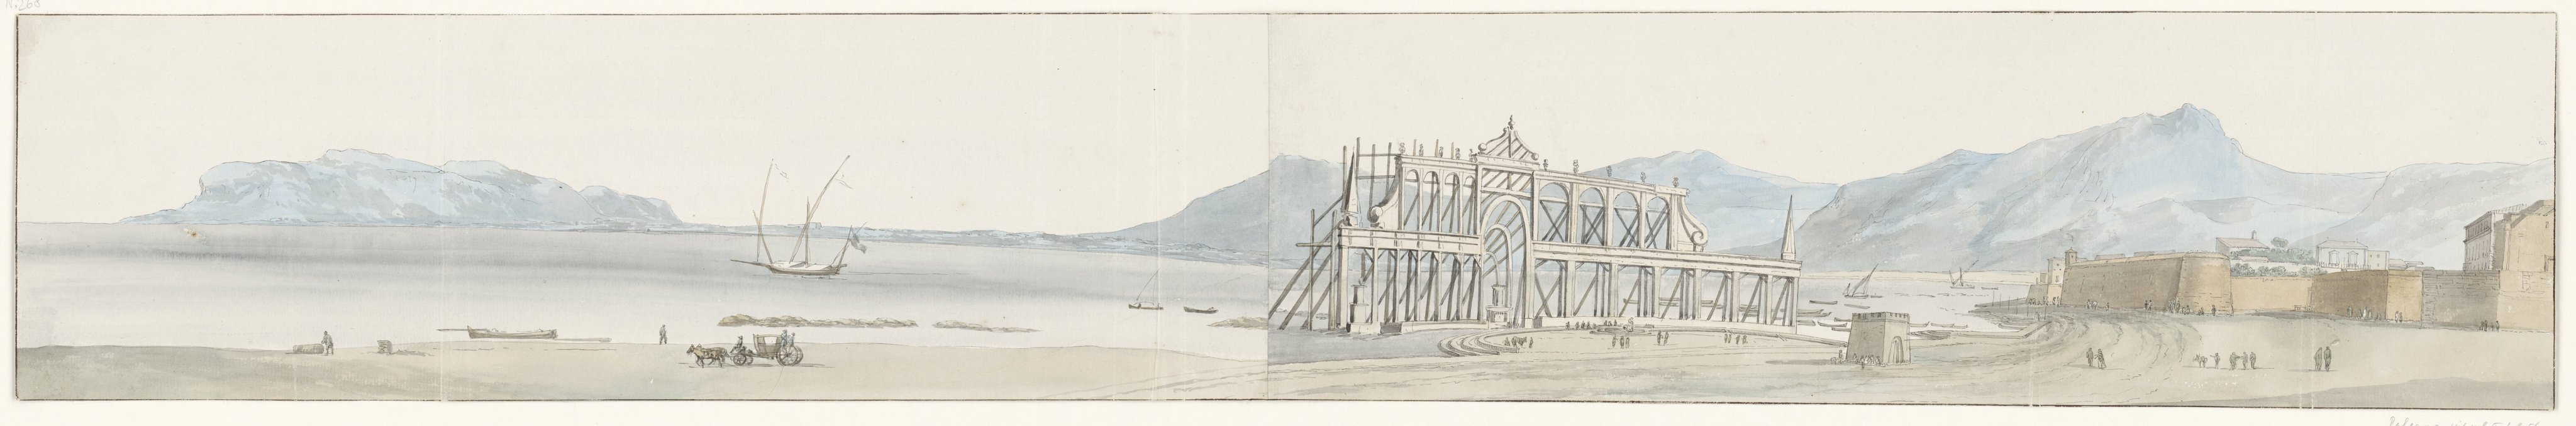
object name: watercolor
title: Voyage en Italie, en Sicile et à Malte - 1778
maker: louis ducros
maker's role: draughtsman, print maker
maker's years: 1748-1810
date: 1778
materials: chalk, paper, watercolor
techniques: brush, pen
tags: city-view, and landscape with man-made constructions, bastion, bulwark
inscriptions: inscription: ‘No 268 Vue de la Marine ou du Cours de Palerme’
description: Tekening uit het album 'Voyage en Italie, en Sicile et à Malte', 1778.